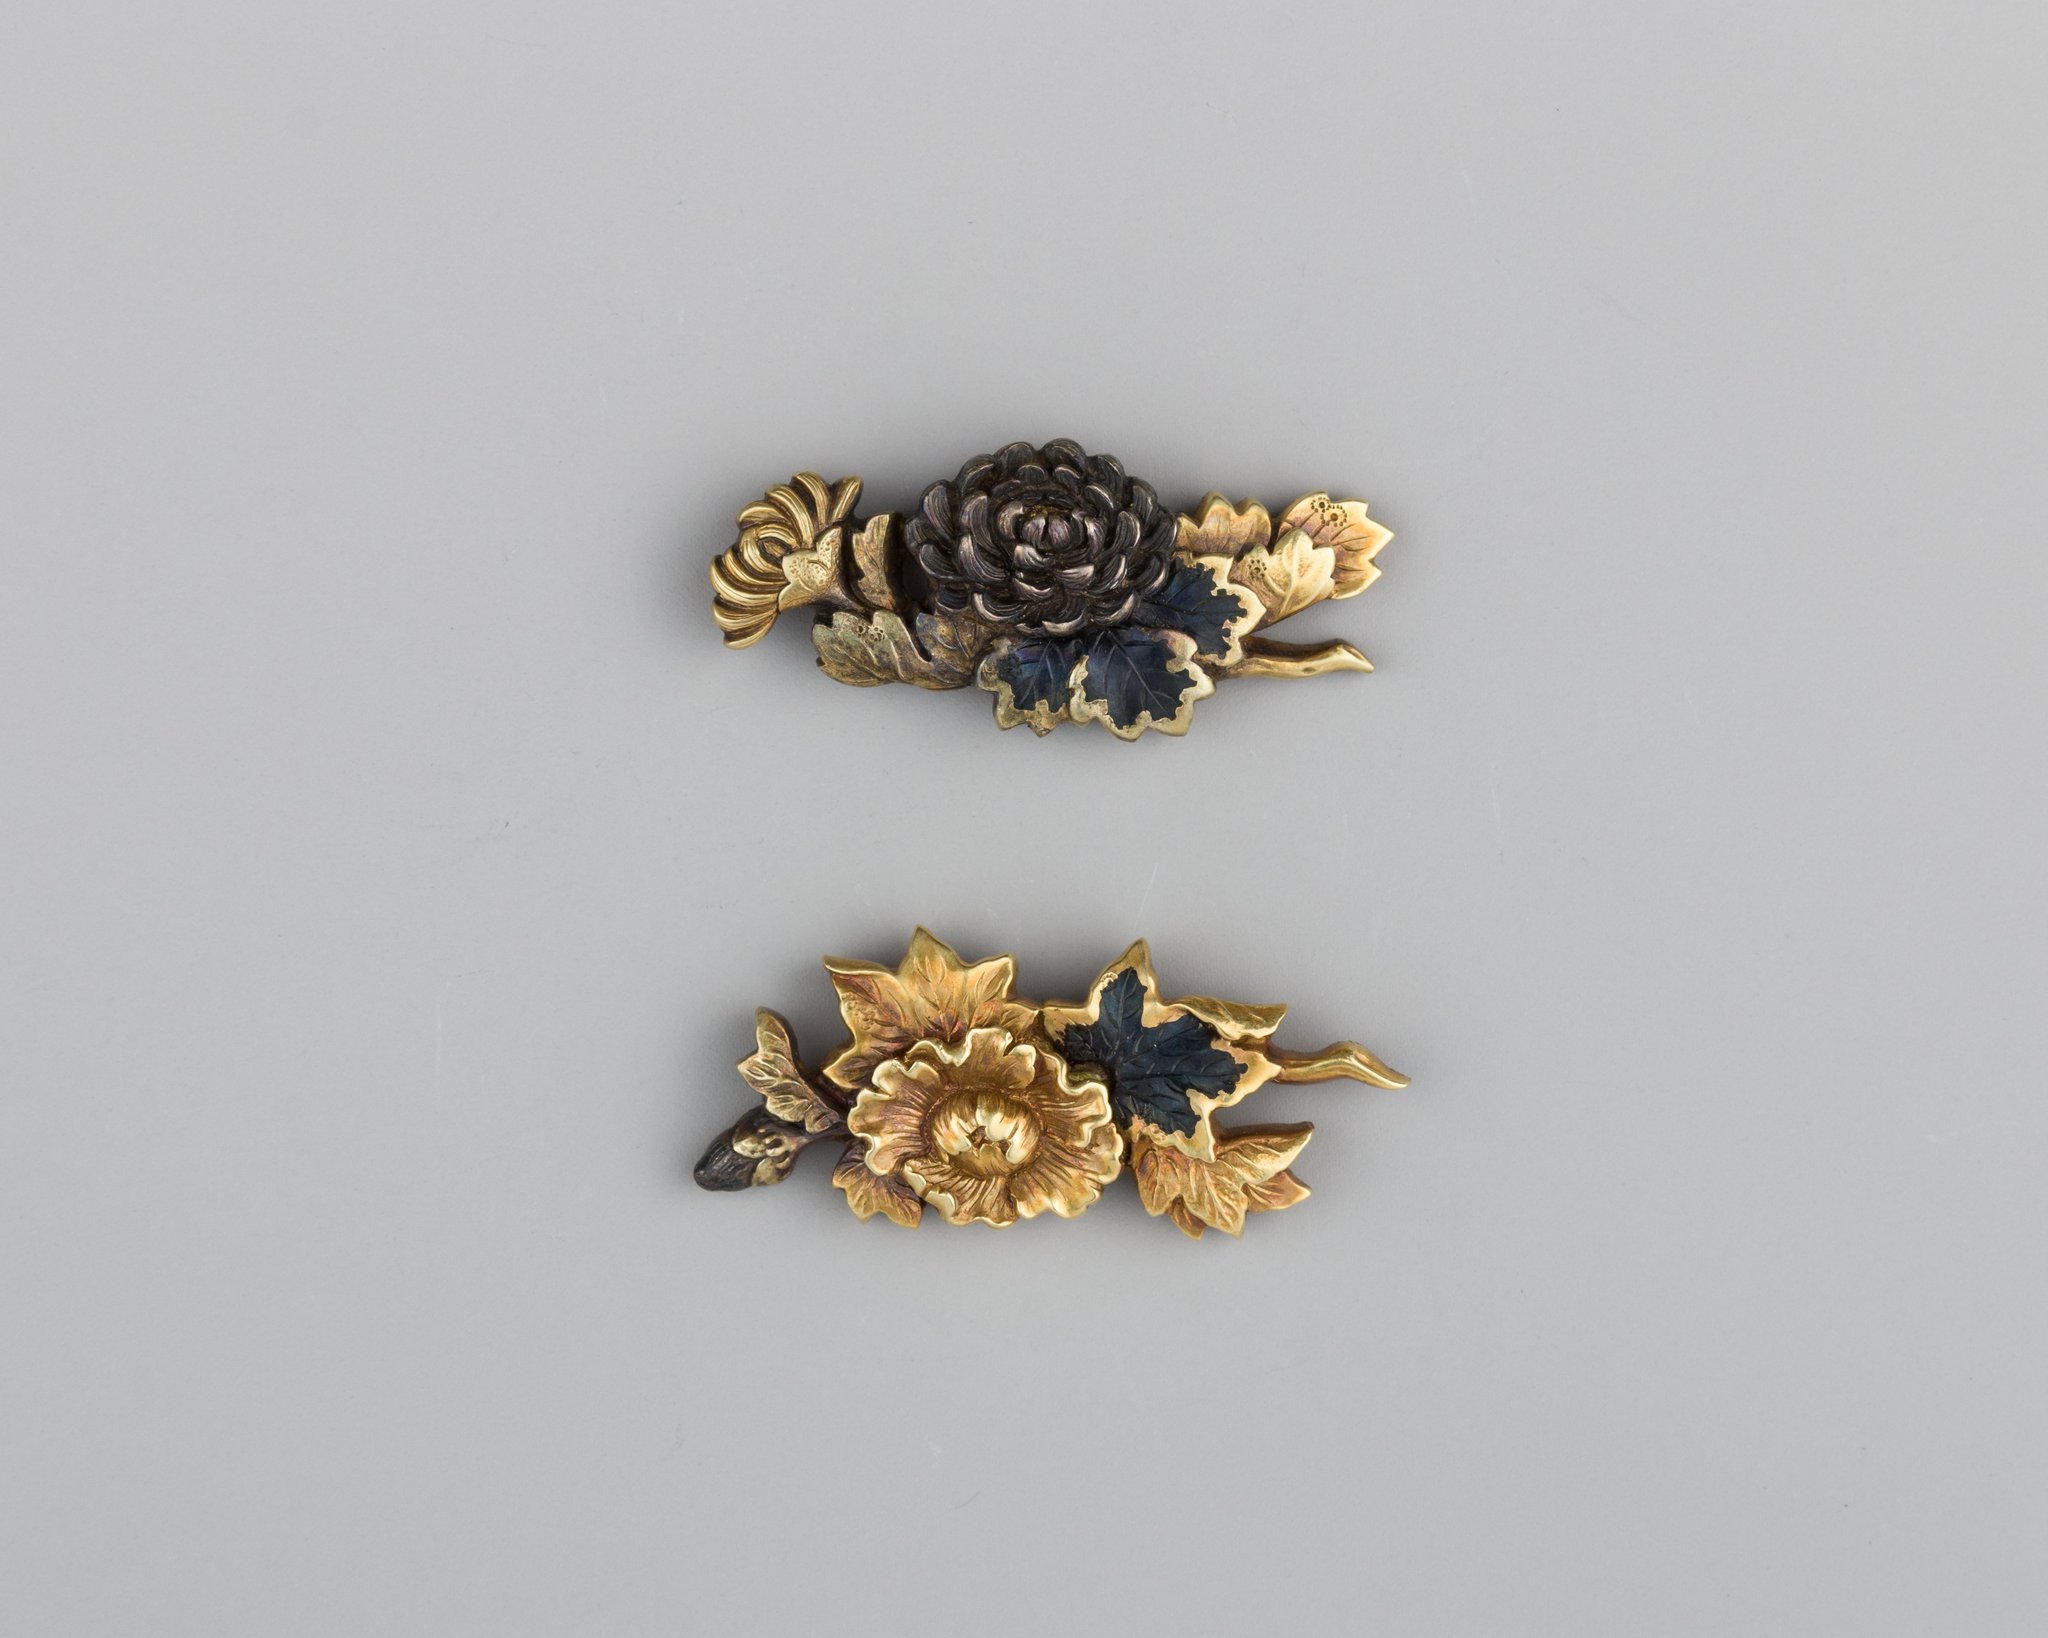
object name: pair of sword grip ornament menuki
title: Pair of Sword-Grip Ornaments (Menuki)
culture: japanese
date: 1701-1800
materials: gold alloy, silver alloy, gold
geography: japan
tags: flowers